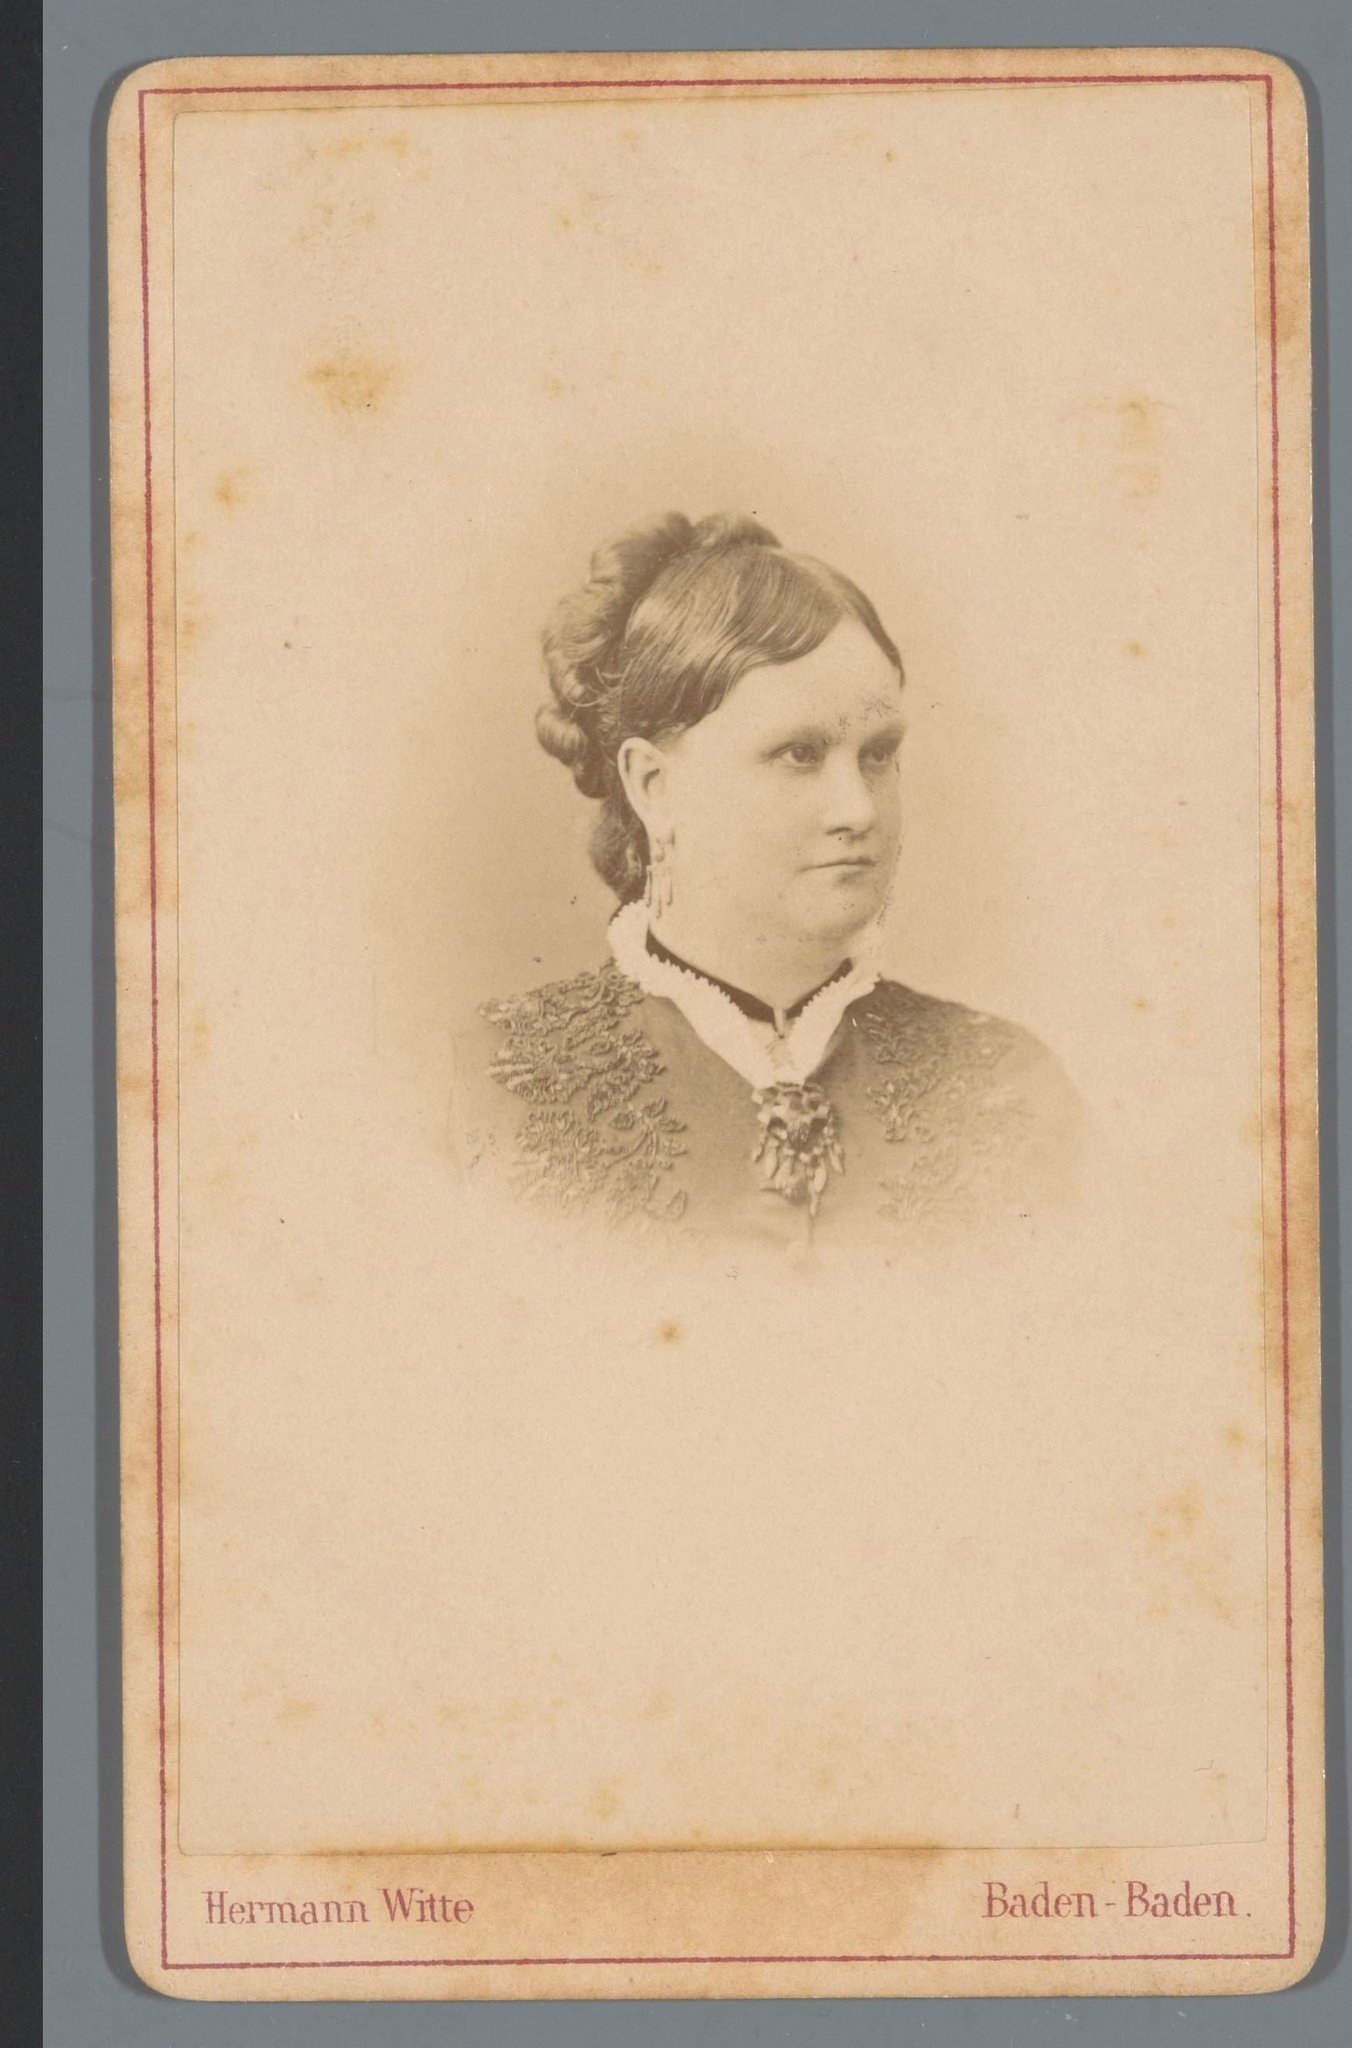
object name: photograph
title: Portret van een onbekende vrouw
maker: hermann witte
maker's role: fotograaf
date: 1872-1874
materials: cardboard, paper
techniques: albumen print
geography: baden-baden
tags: adult woman, anonymous historical person portrayed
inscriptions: address: ‘Schillerstrasse/ BADEN-BADEN.’, inscription: ‘Die Platte wird zum Nachbestellungen aufbewahrt.’